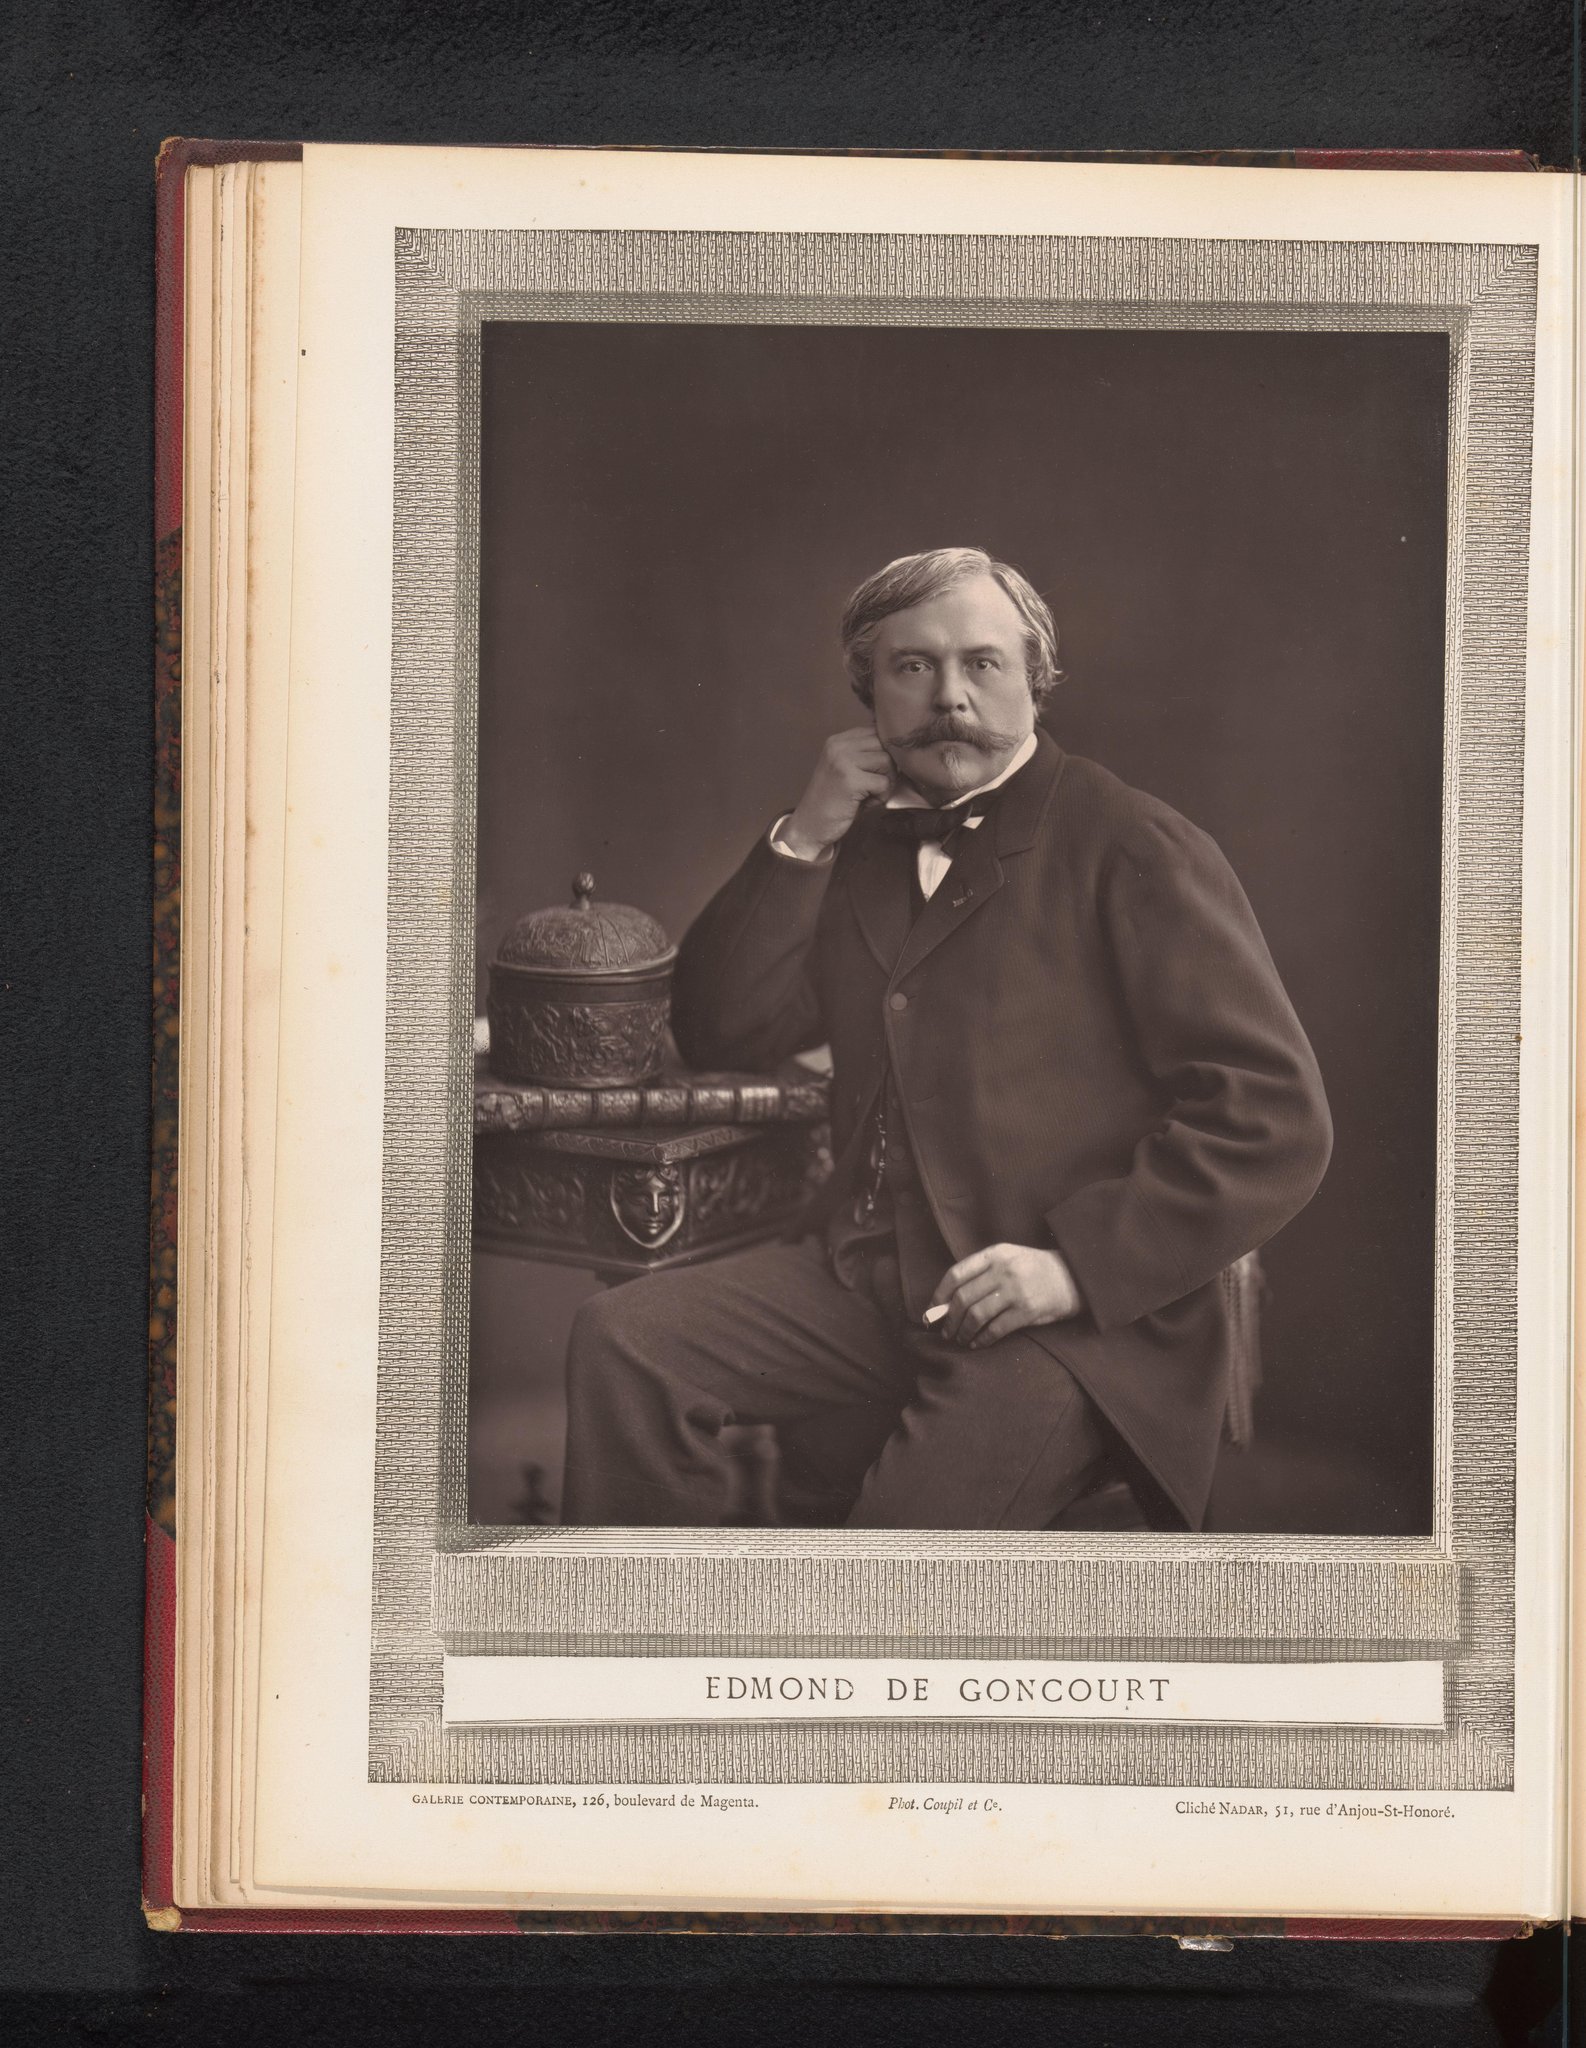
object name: photomechanical print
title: Portret van Edmond de Goncourt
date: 1871-1876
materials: paper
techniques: woodburytype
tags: painter, draughtsman, edmond de goncourt, adult man, historical persons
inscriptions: inscription: ‘Galerie Contemporaine, 126, boulevard de Magenta.’